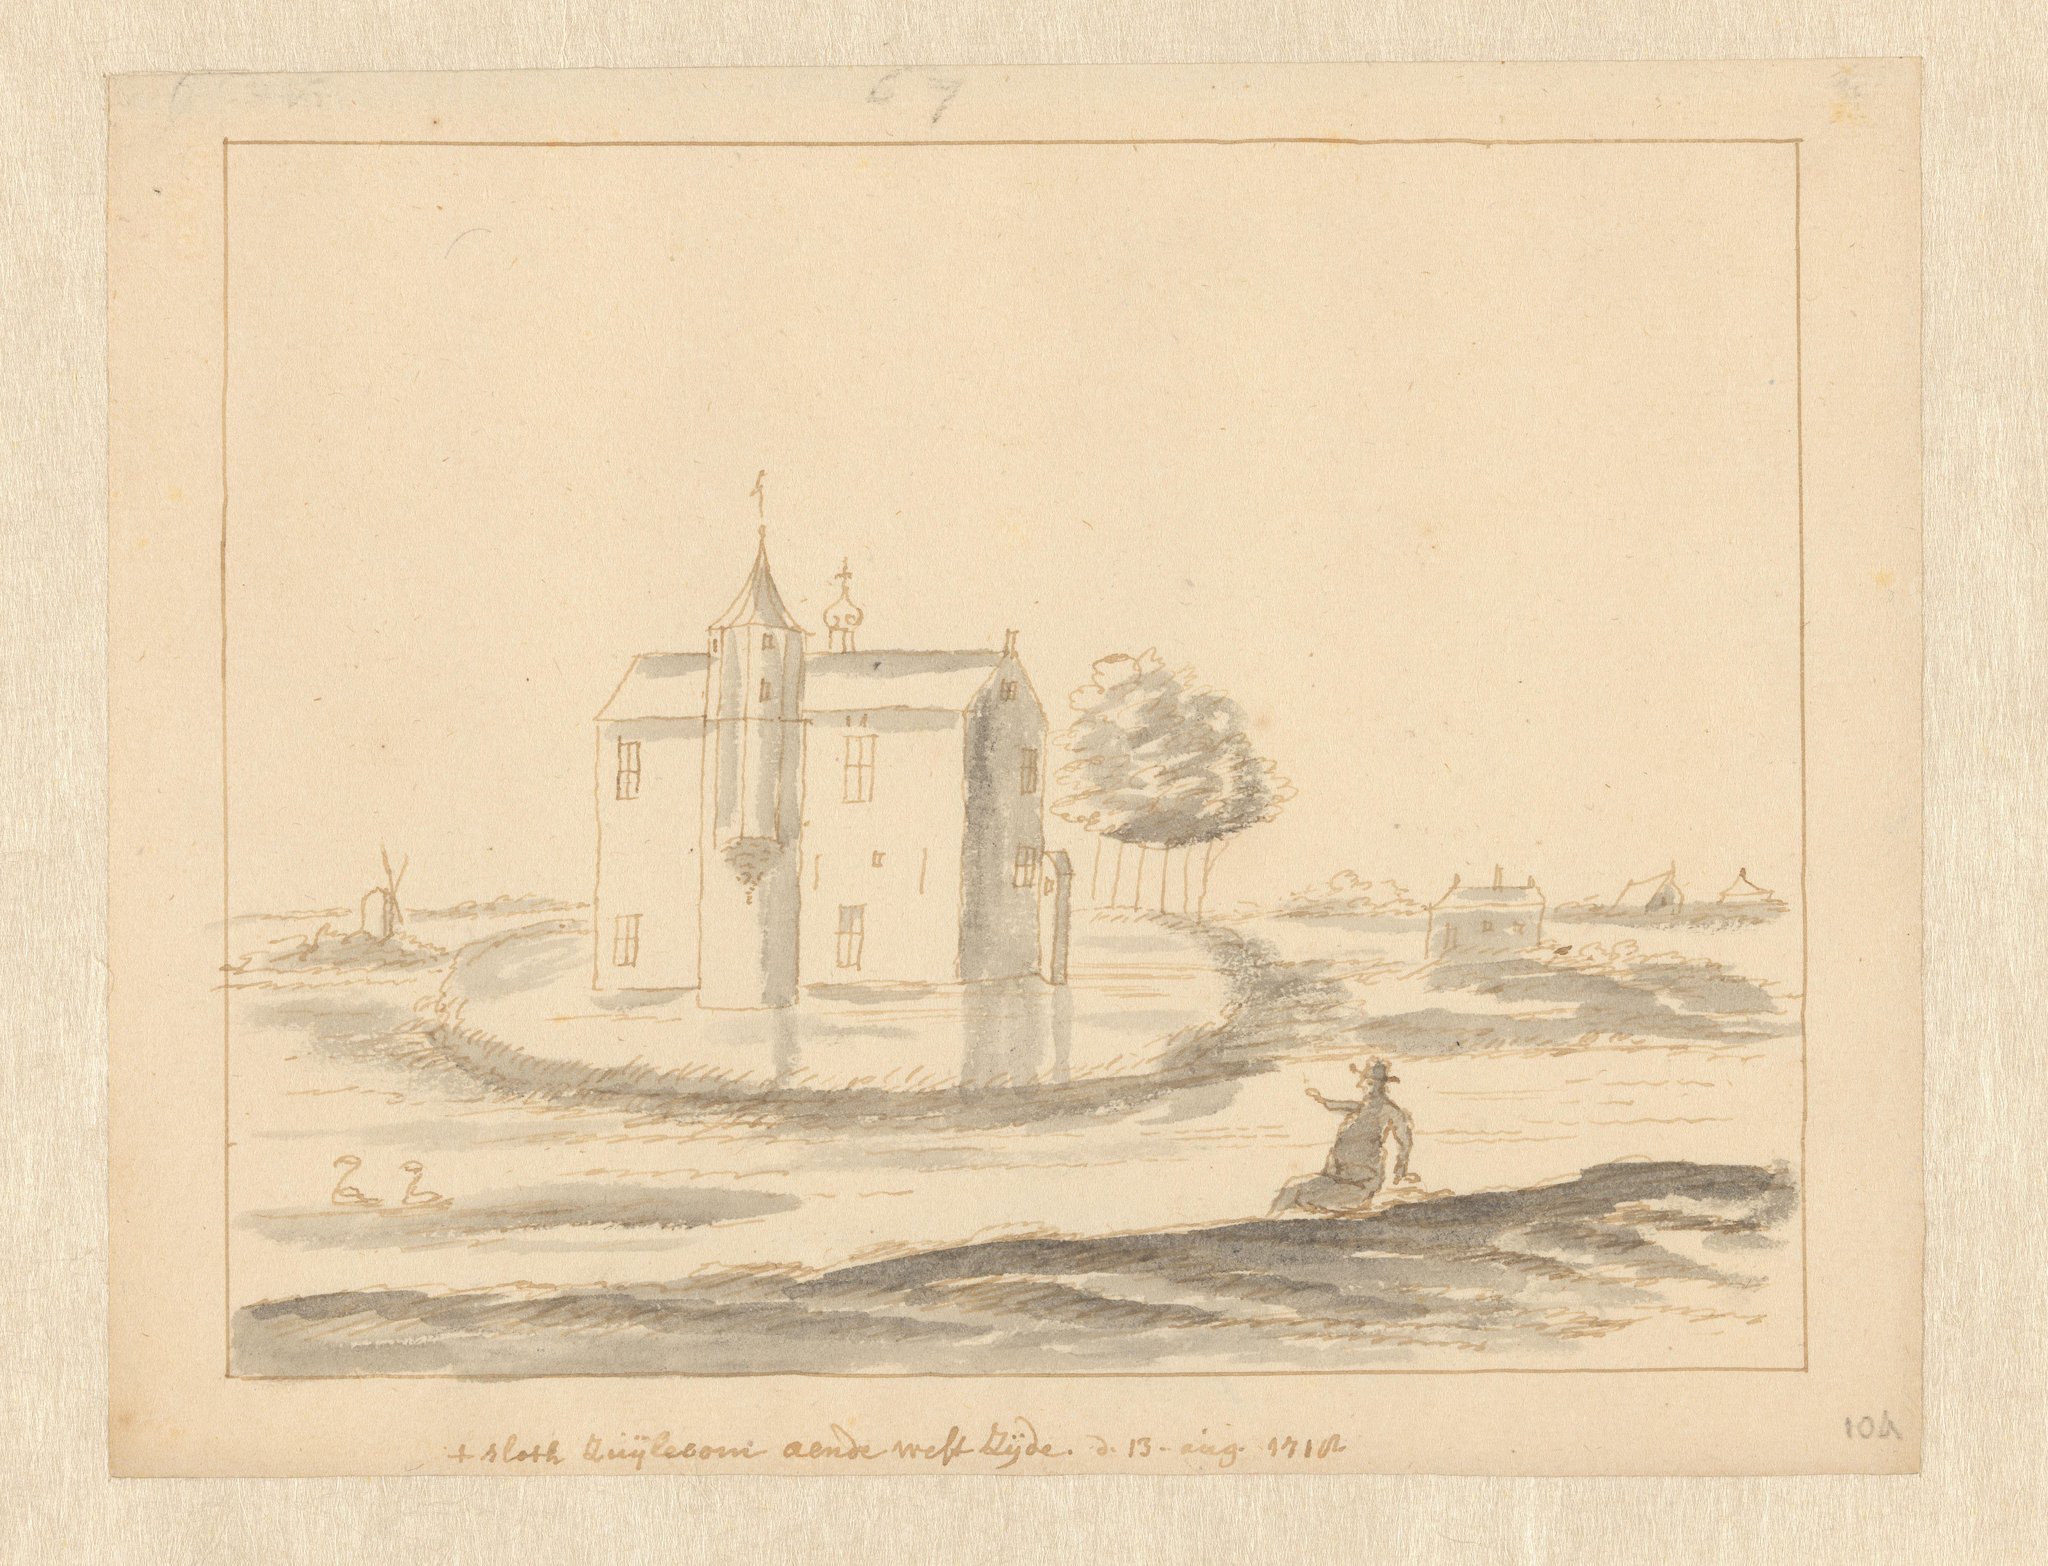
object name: drawing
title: Kasteel Zuilichem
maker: Anonymous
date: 1718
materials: ink, paper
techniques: brush, pen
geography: gelderland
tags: castle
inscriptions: number: ‘104’, date and inscription: ‘'t sloth Zuijlecem aende west zijde. d. 13.aug. 1718’